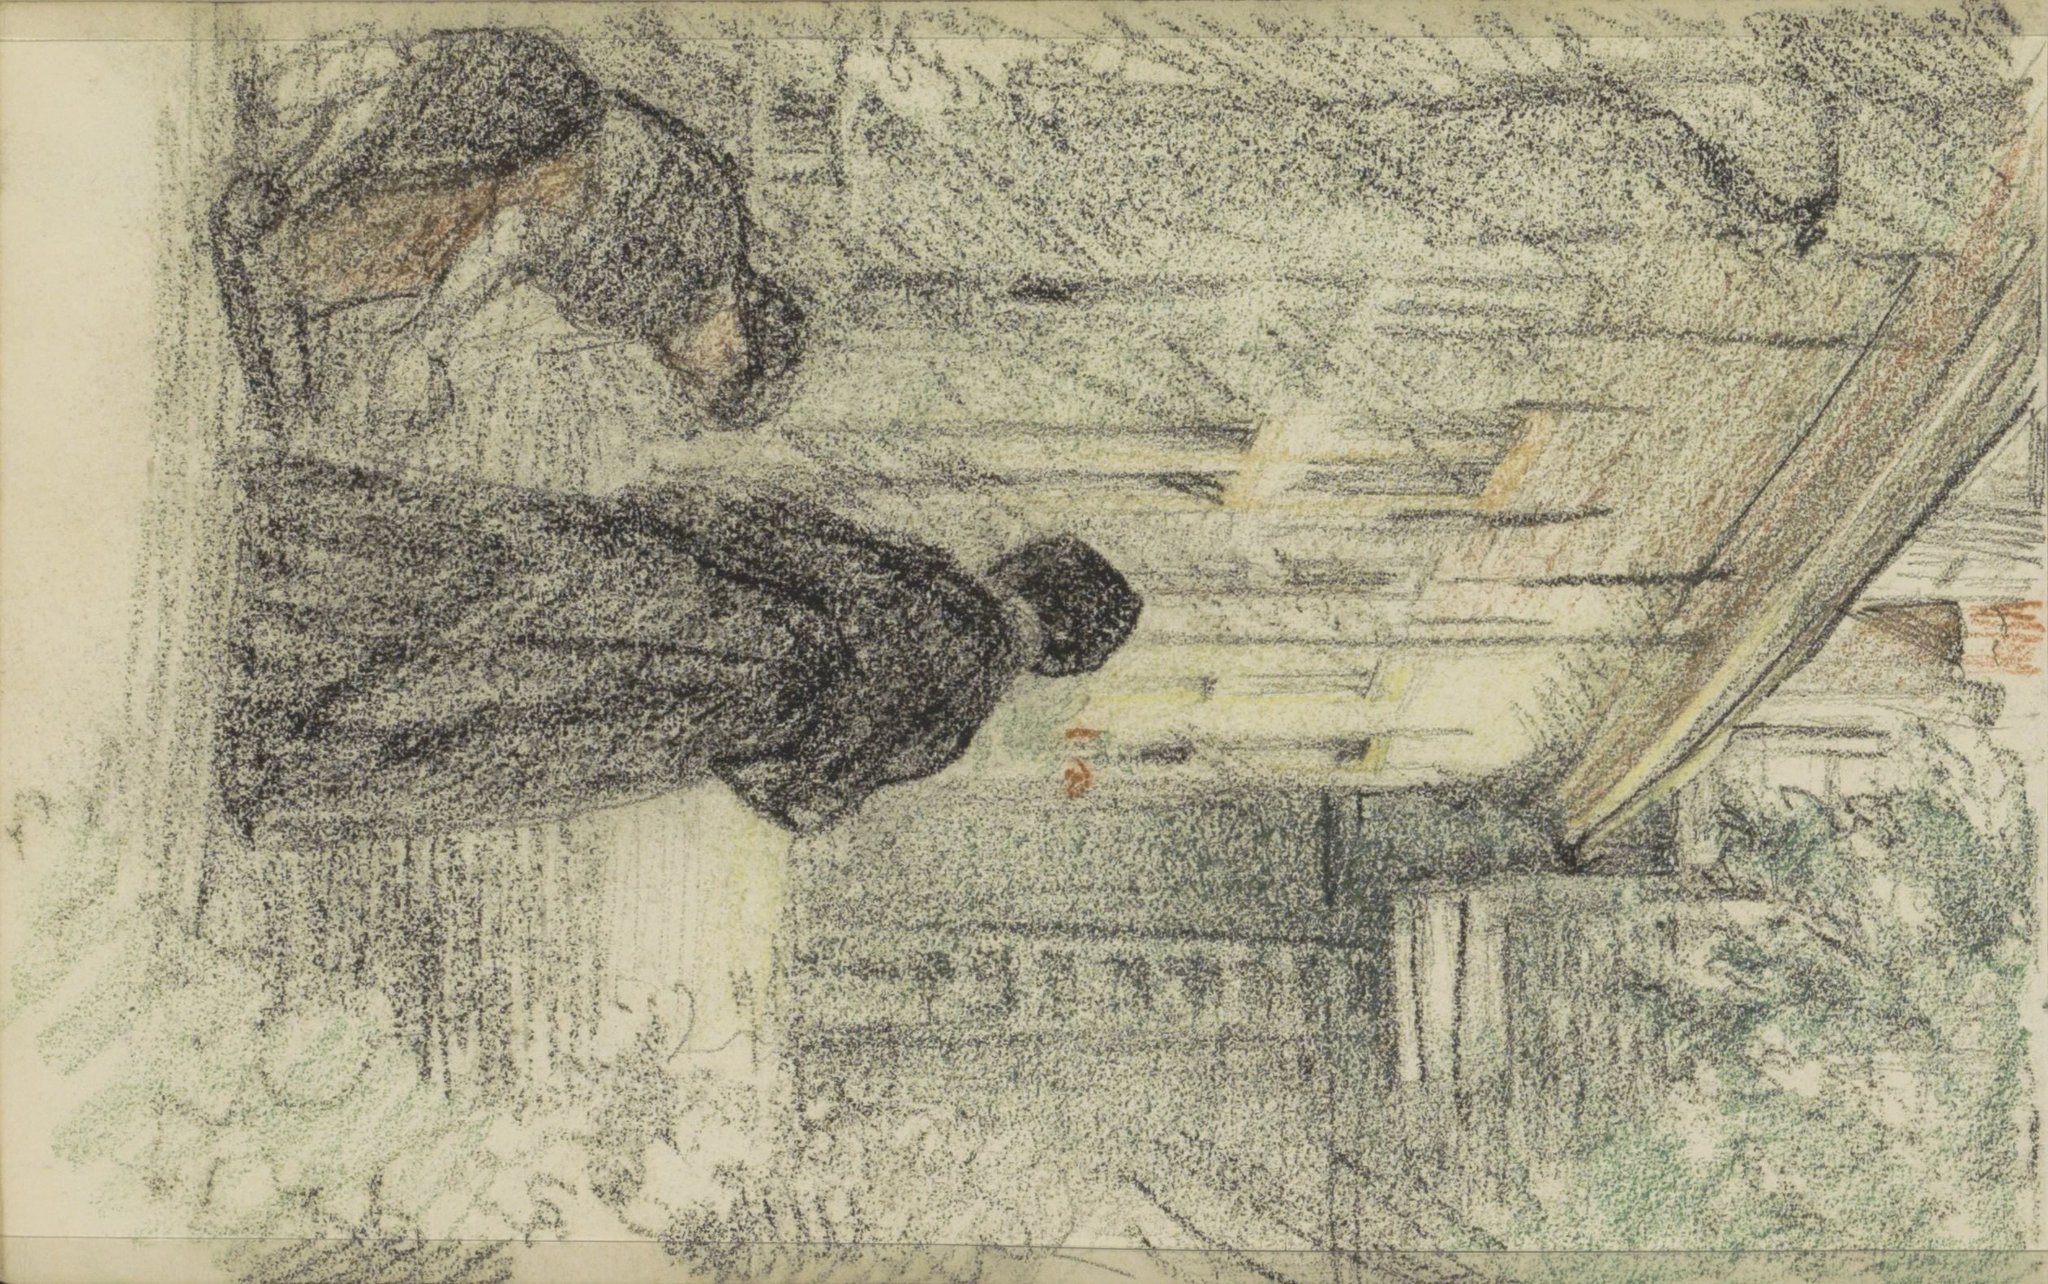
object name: sketchbook leaf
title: Twee vrouwen op een binnenplaats tussen de huizen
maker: a.a.l. de grammont-hubrecht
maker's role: draughtsman, painter, print maker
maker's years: 1855-1913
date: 1892-1913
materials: chalk, paper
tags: adult woman, courtyard, street (+ city(-scape) with figures, staffage)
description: Blad 21 verso uit een schetsboek met 31 bladen.